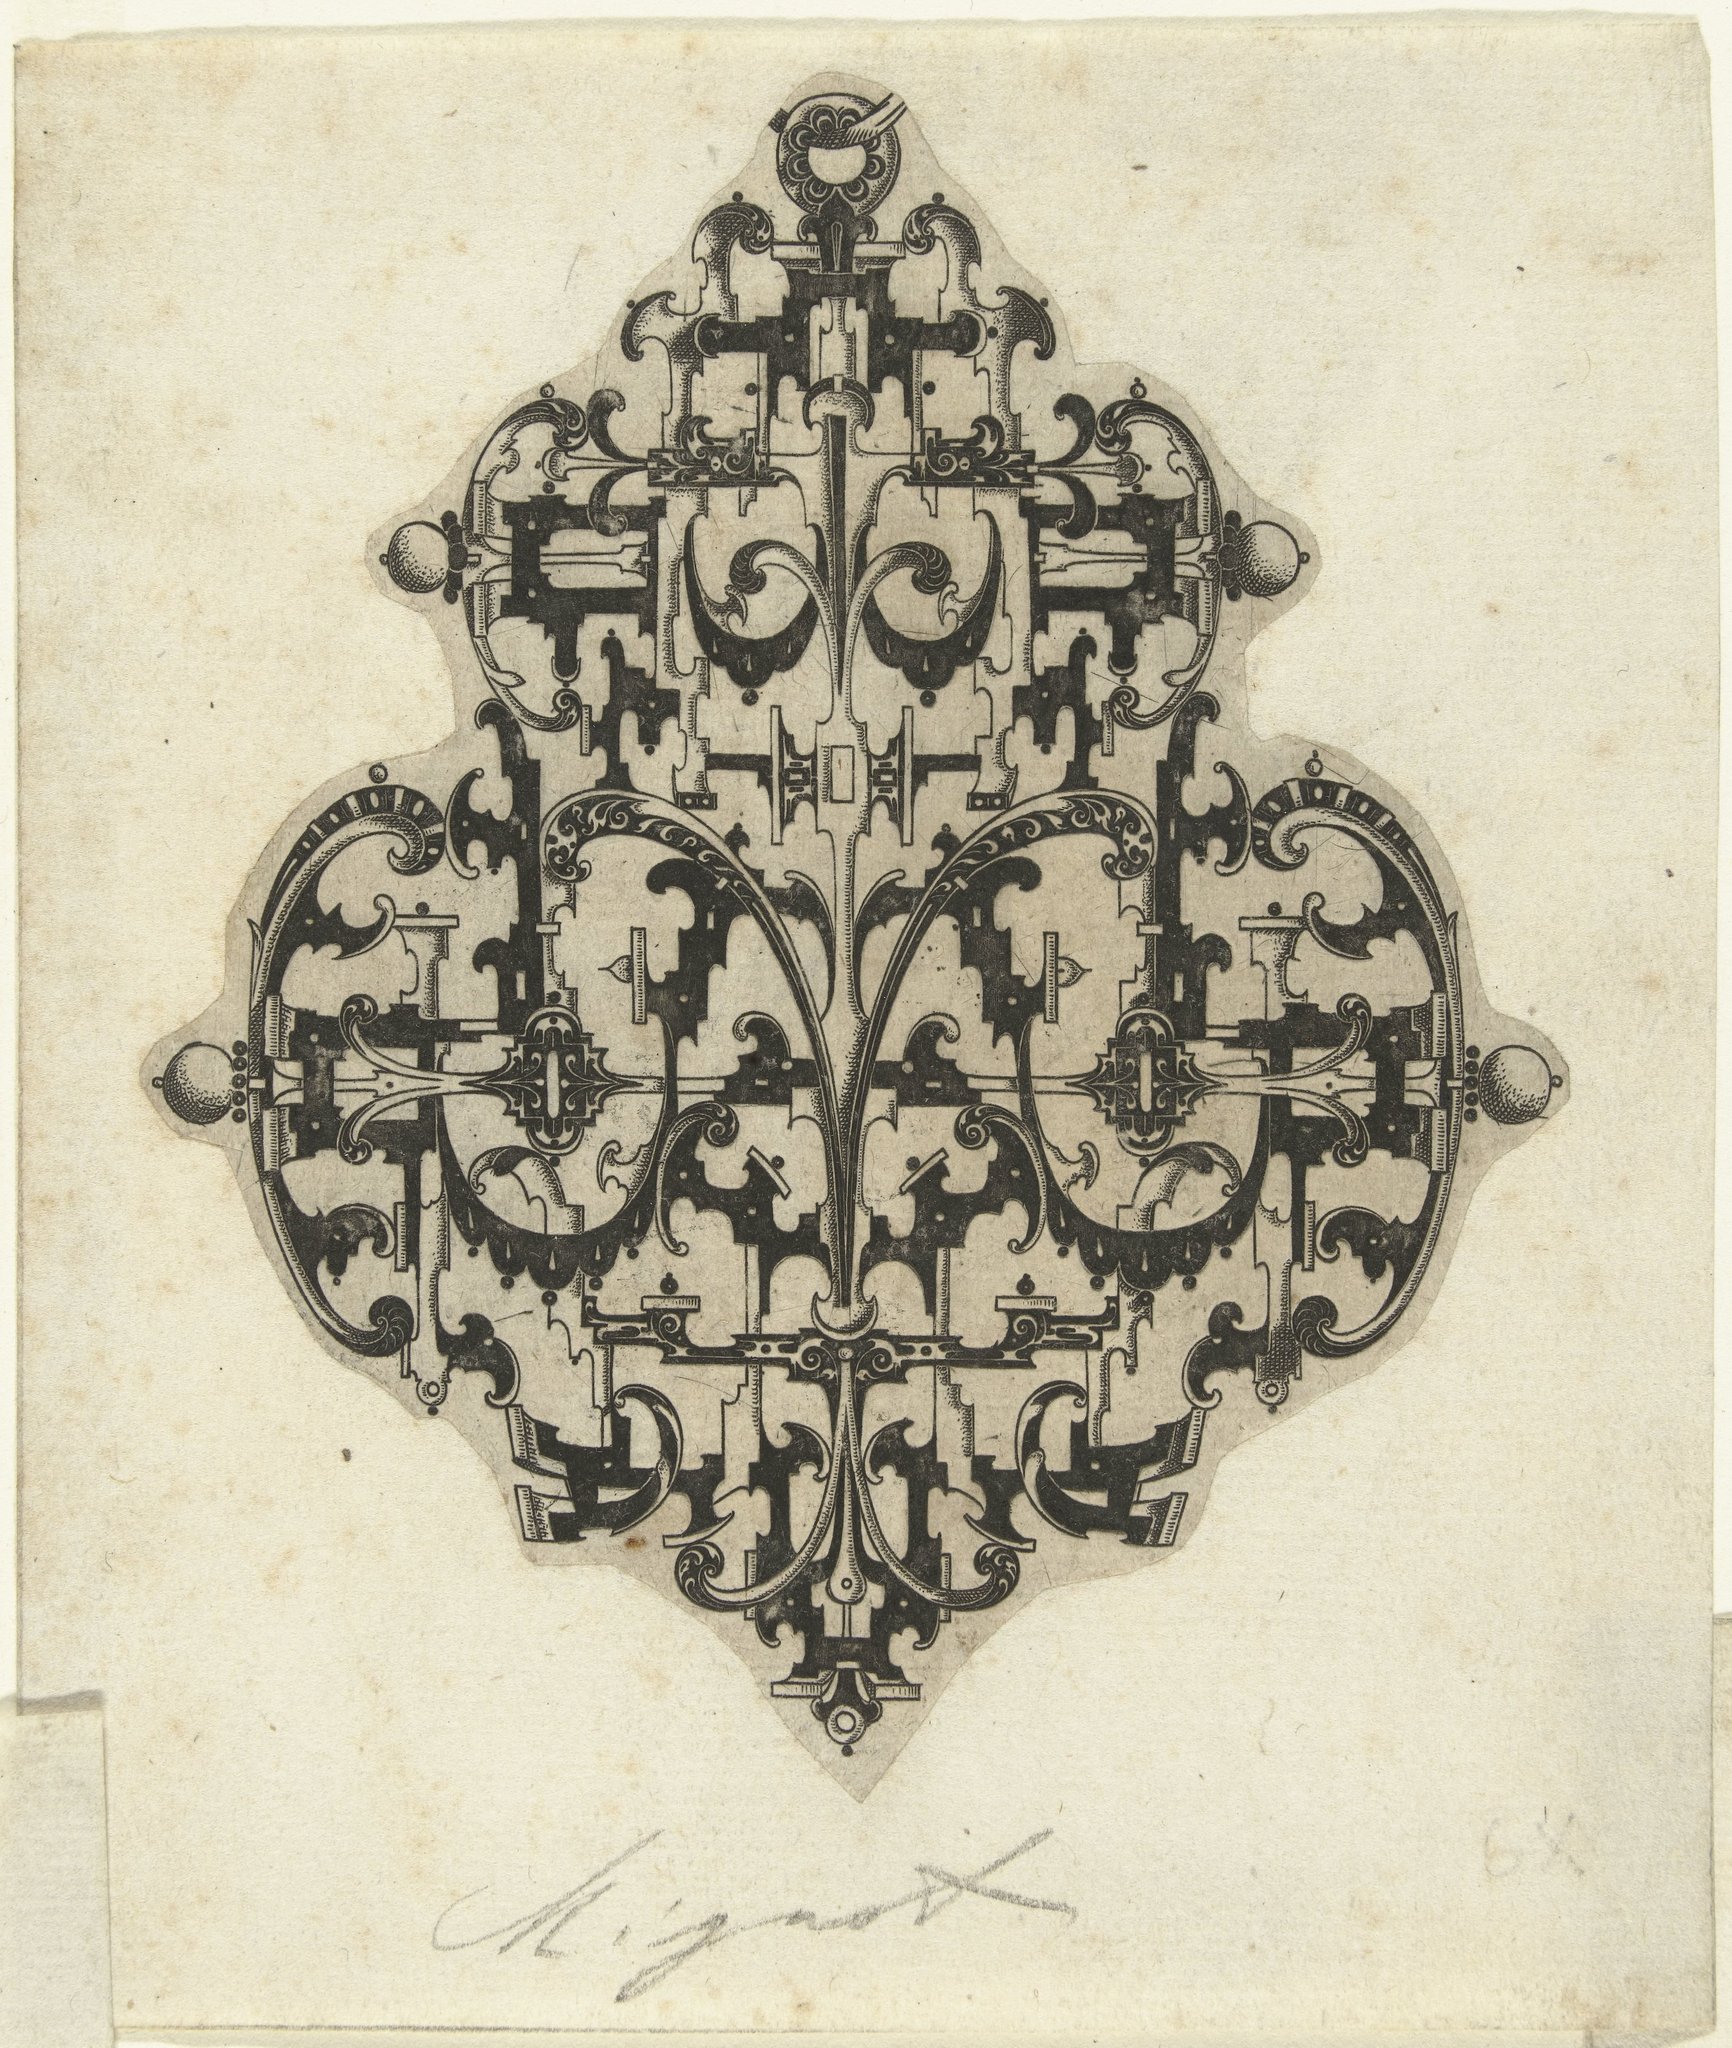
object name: ornament print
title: In timore de (...)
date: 1596-1616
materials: paper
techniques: engraving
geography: germany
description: Aan de zijkanten zitten vier ronde parels. Afkomstig uit een serie, bestaande uit een titelblad en 7 bladen met hangers.